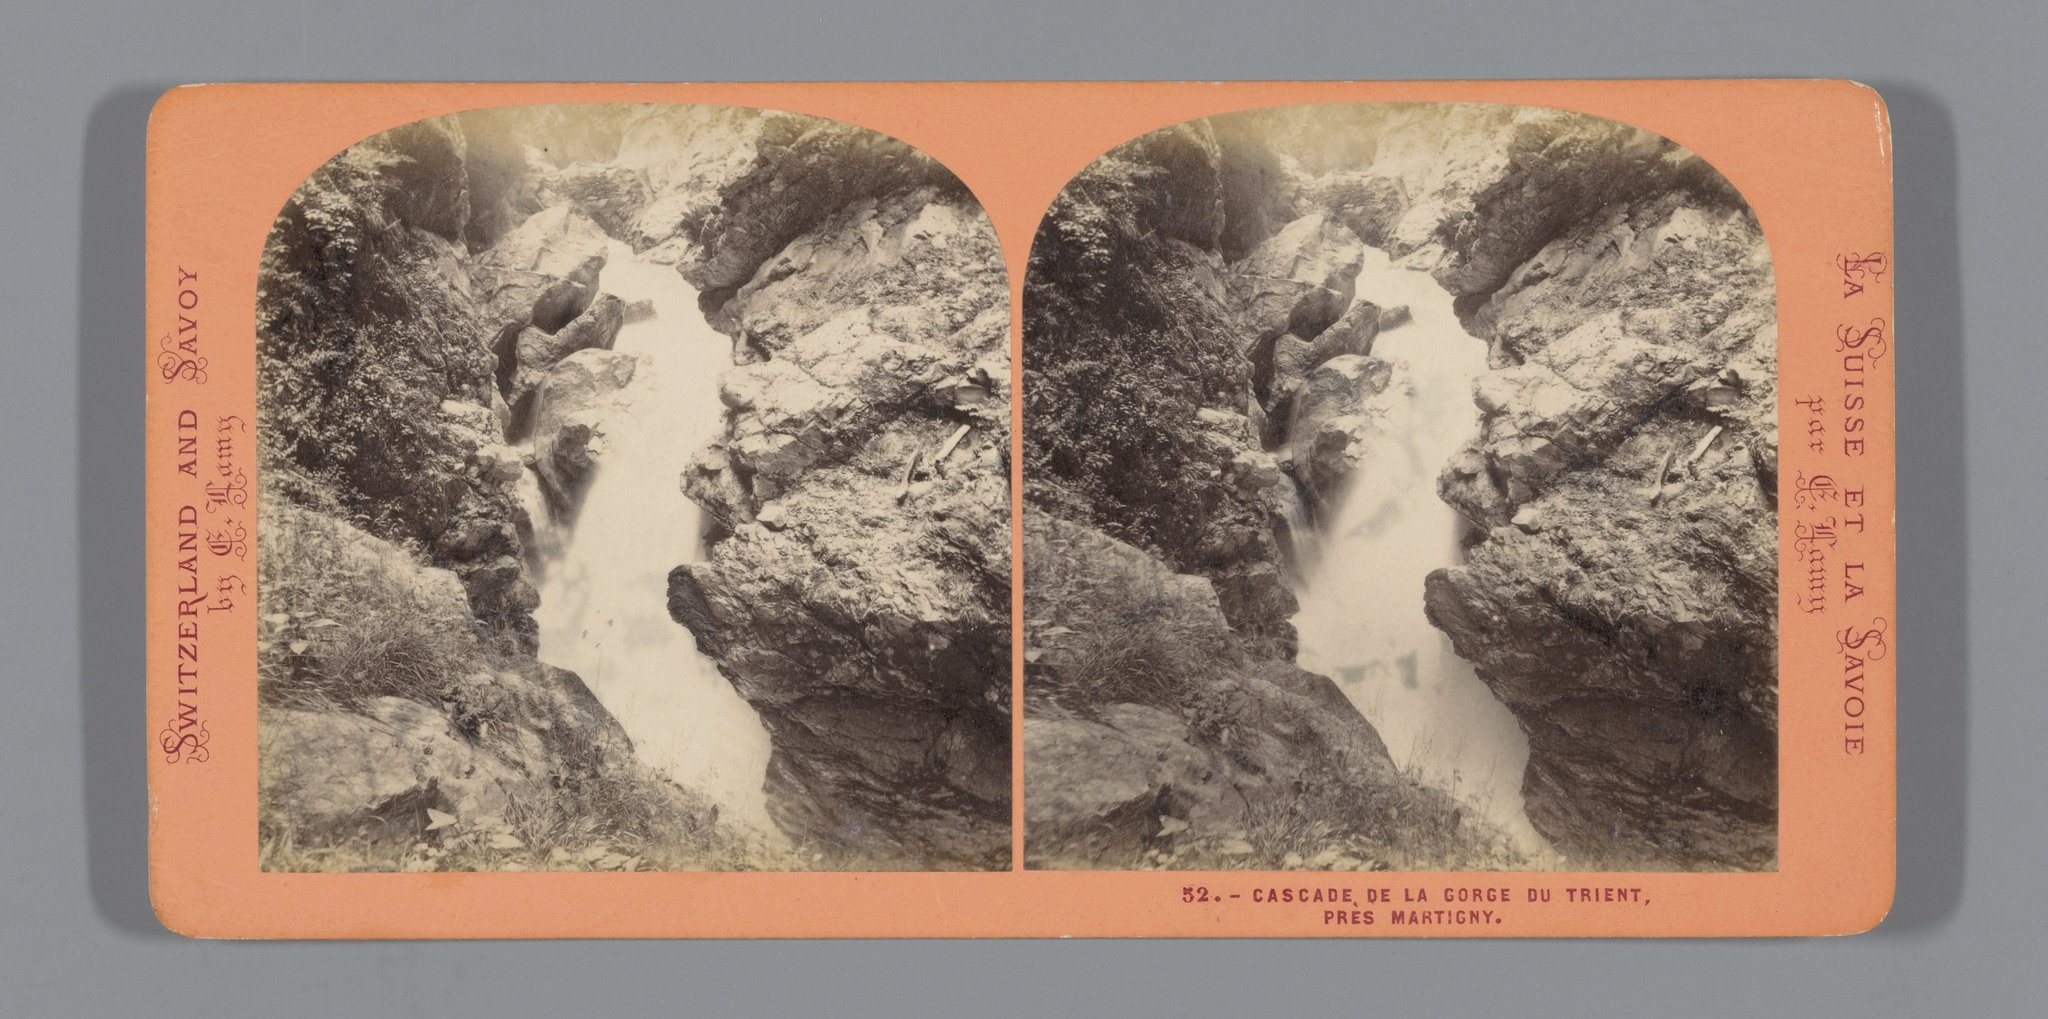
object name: stereograph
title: La Suisse et la Savoie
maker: ernest eléonor pierre lamy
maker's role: publisher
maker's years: 1828-1900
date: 1860-1880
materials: cardboard, photographic support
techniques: albumen print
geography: switzerland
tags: waterfall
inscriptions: number: ‘52.’